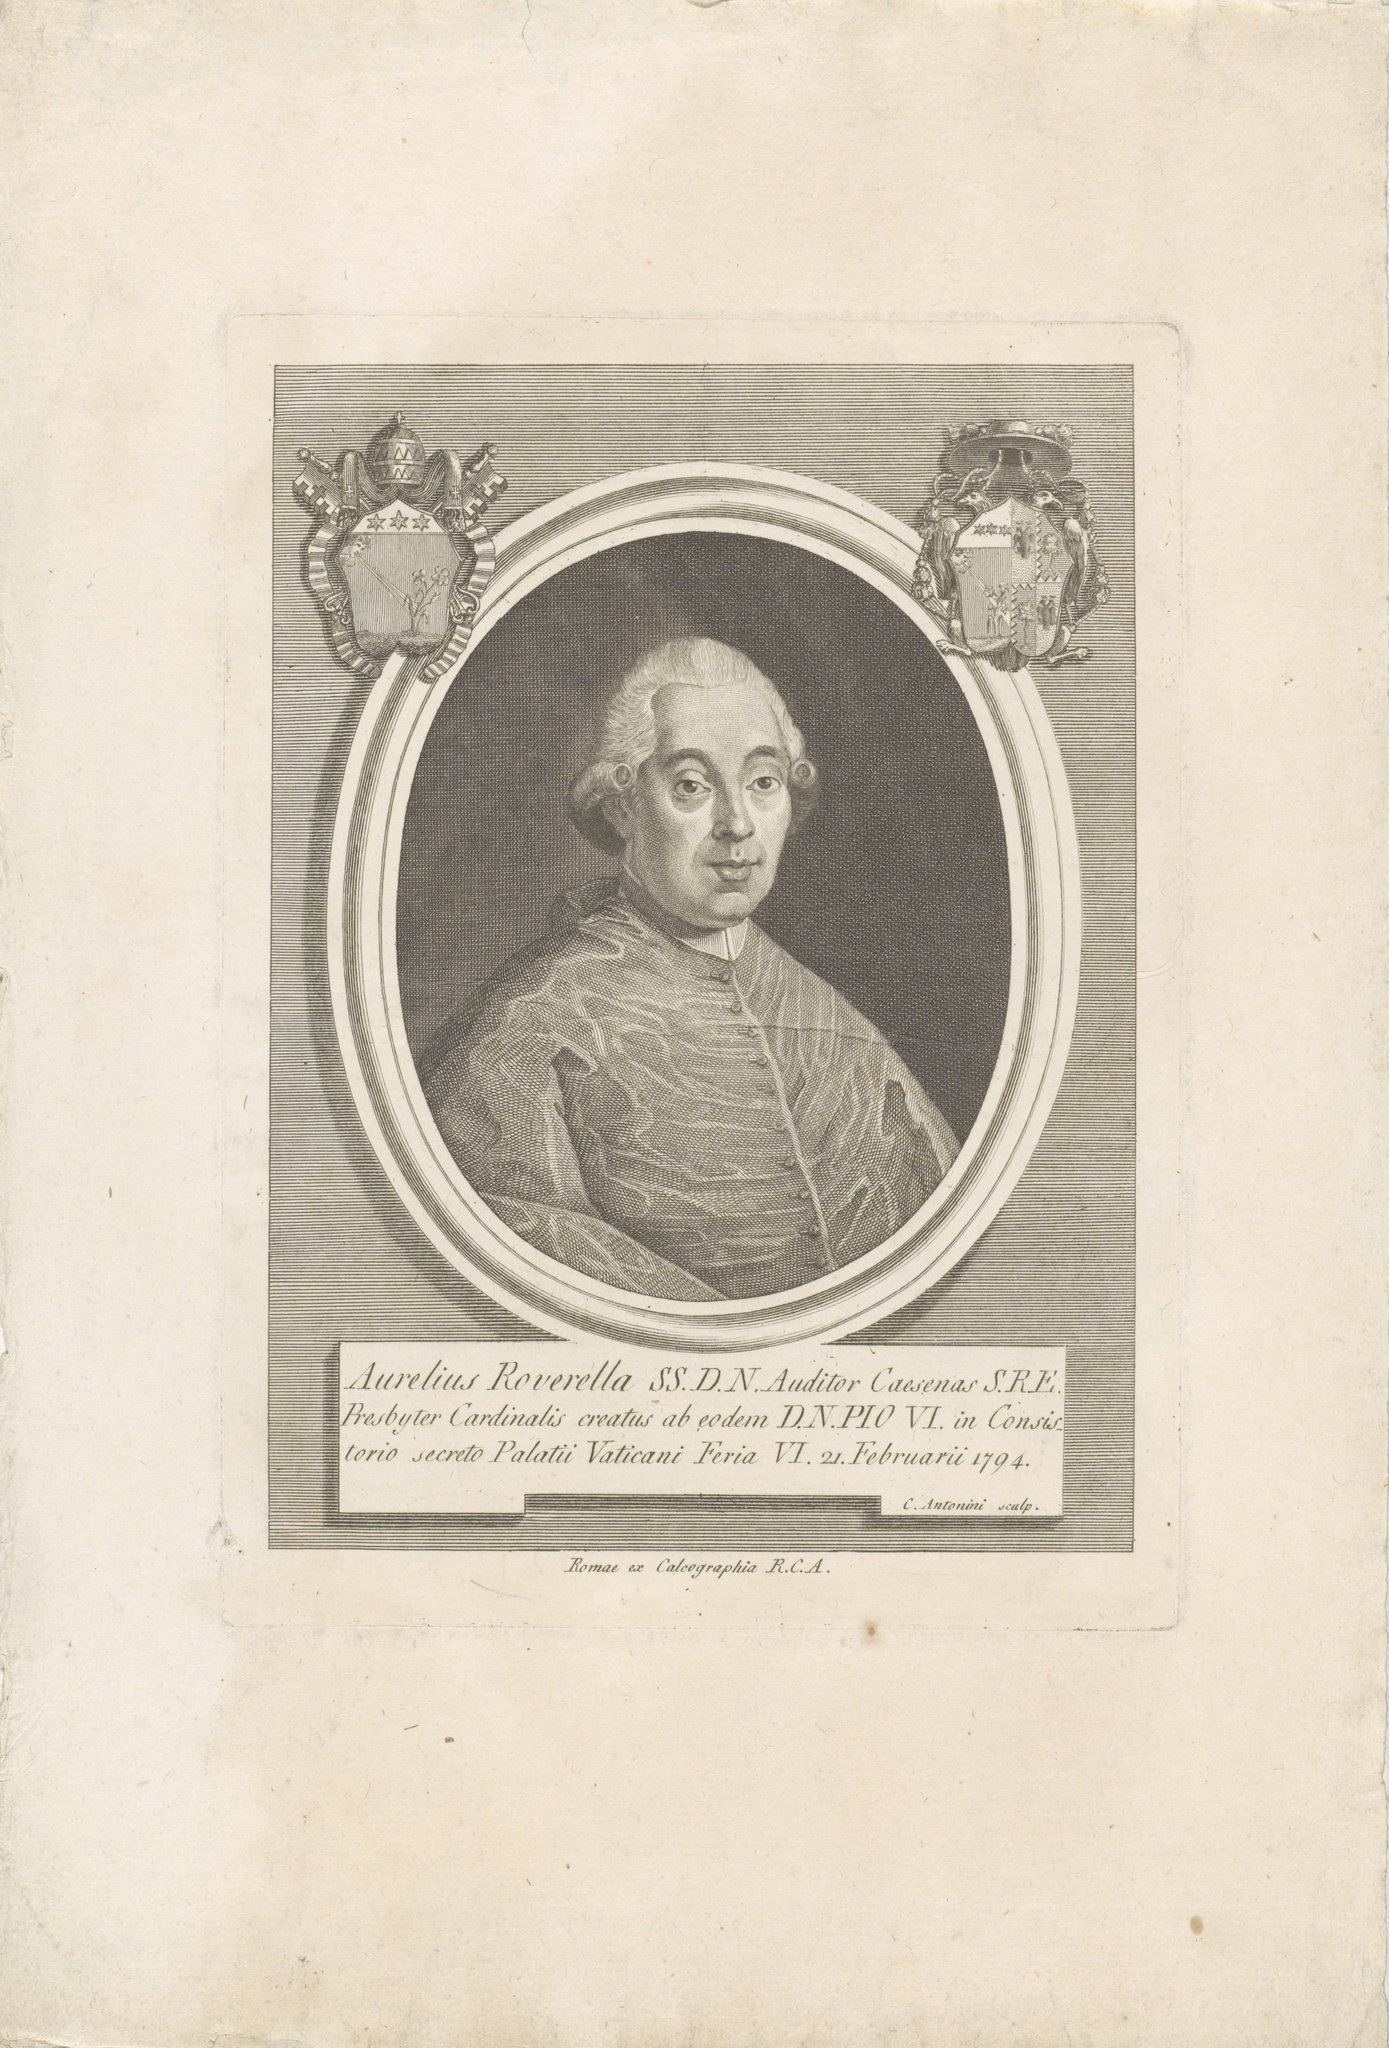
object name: print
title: Portret van Aurelio Roverella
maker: carlo antonini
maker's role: print maker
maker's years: 1749-1835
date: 1795-1805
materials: paper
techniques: engraving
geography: rome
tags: historical persons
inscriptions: collector's mark: Lugt 2228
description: Portret van Kardinaal Aurelio Roverella in een ovaal. Boven twee wapenschilden. Onder het portret een kader met tekst in het Latijn.